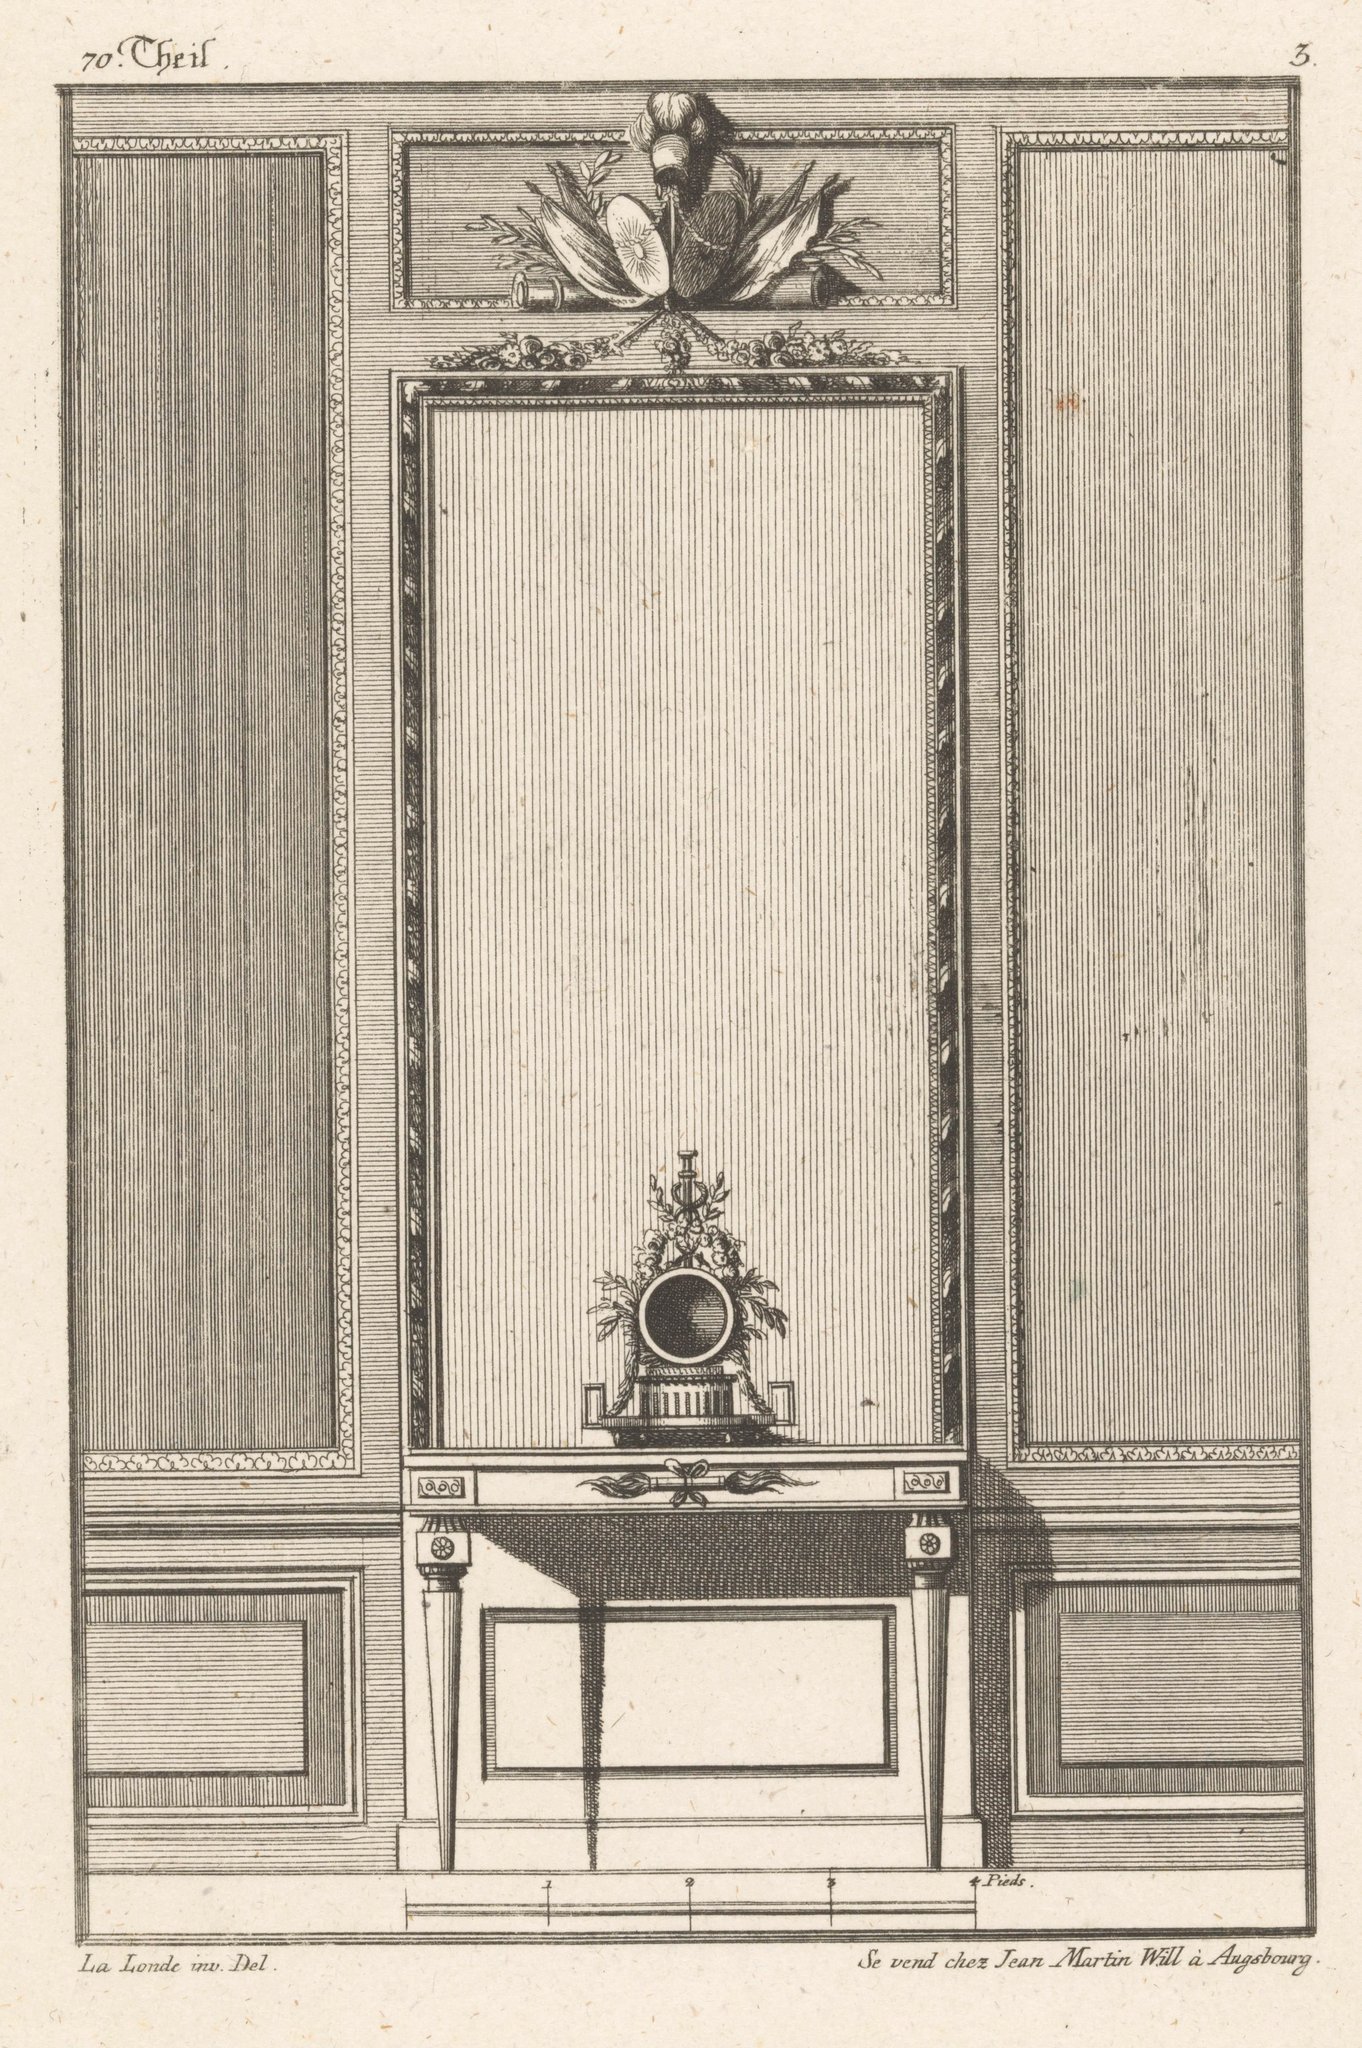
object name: print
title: 70. Theil Cheminées avec leurs Trumeaux &c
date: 1784-1806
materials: paper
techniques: engraving, etching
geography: augsburg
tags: helmet, protective weapons: shield, table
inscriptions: collector's mark: Lugt 2228, collector's mark: Lugt 2760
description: Een geornamenteerde tafel met een pendule en aan de bovenzijde een paneel met een helm, schilden, vlaggen en wapens.